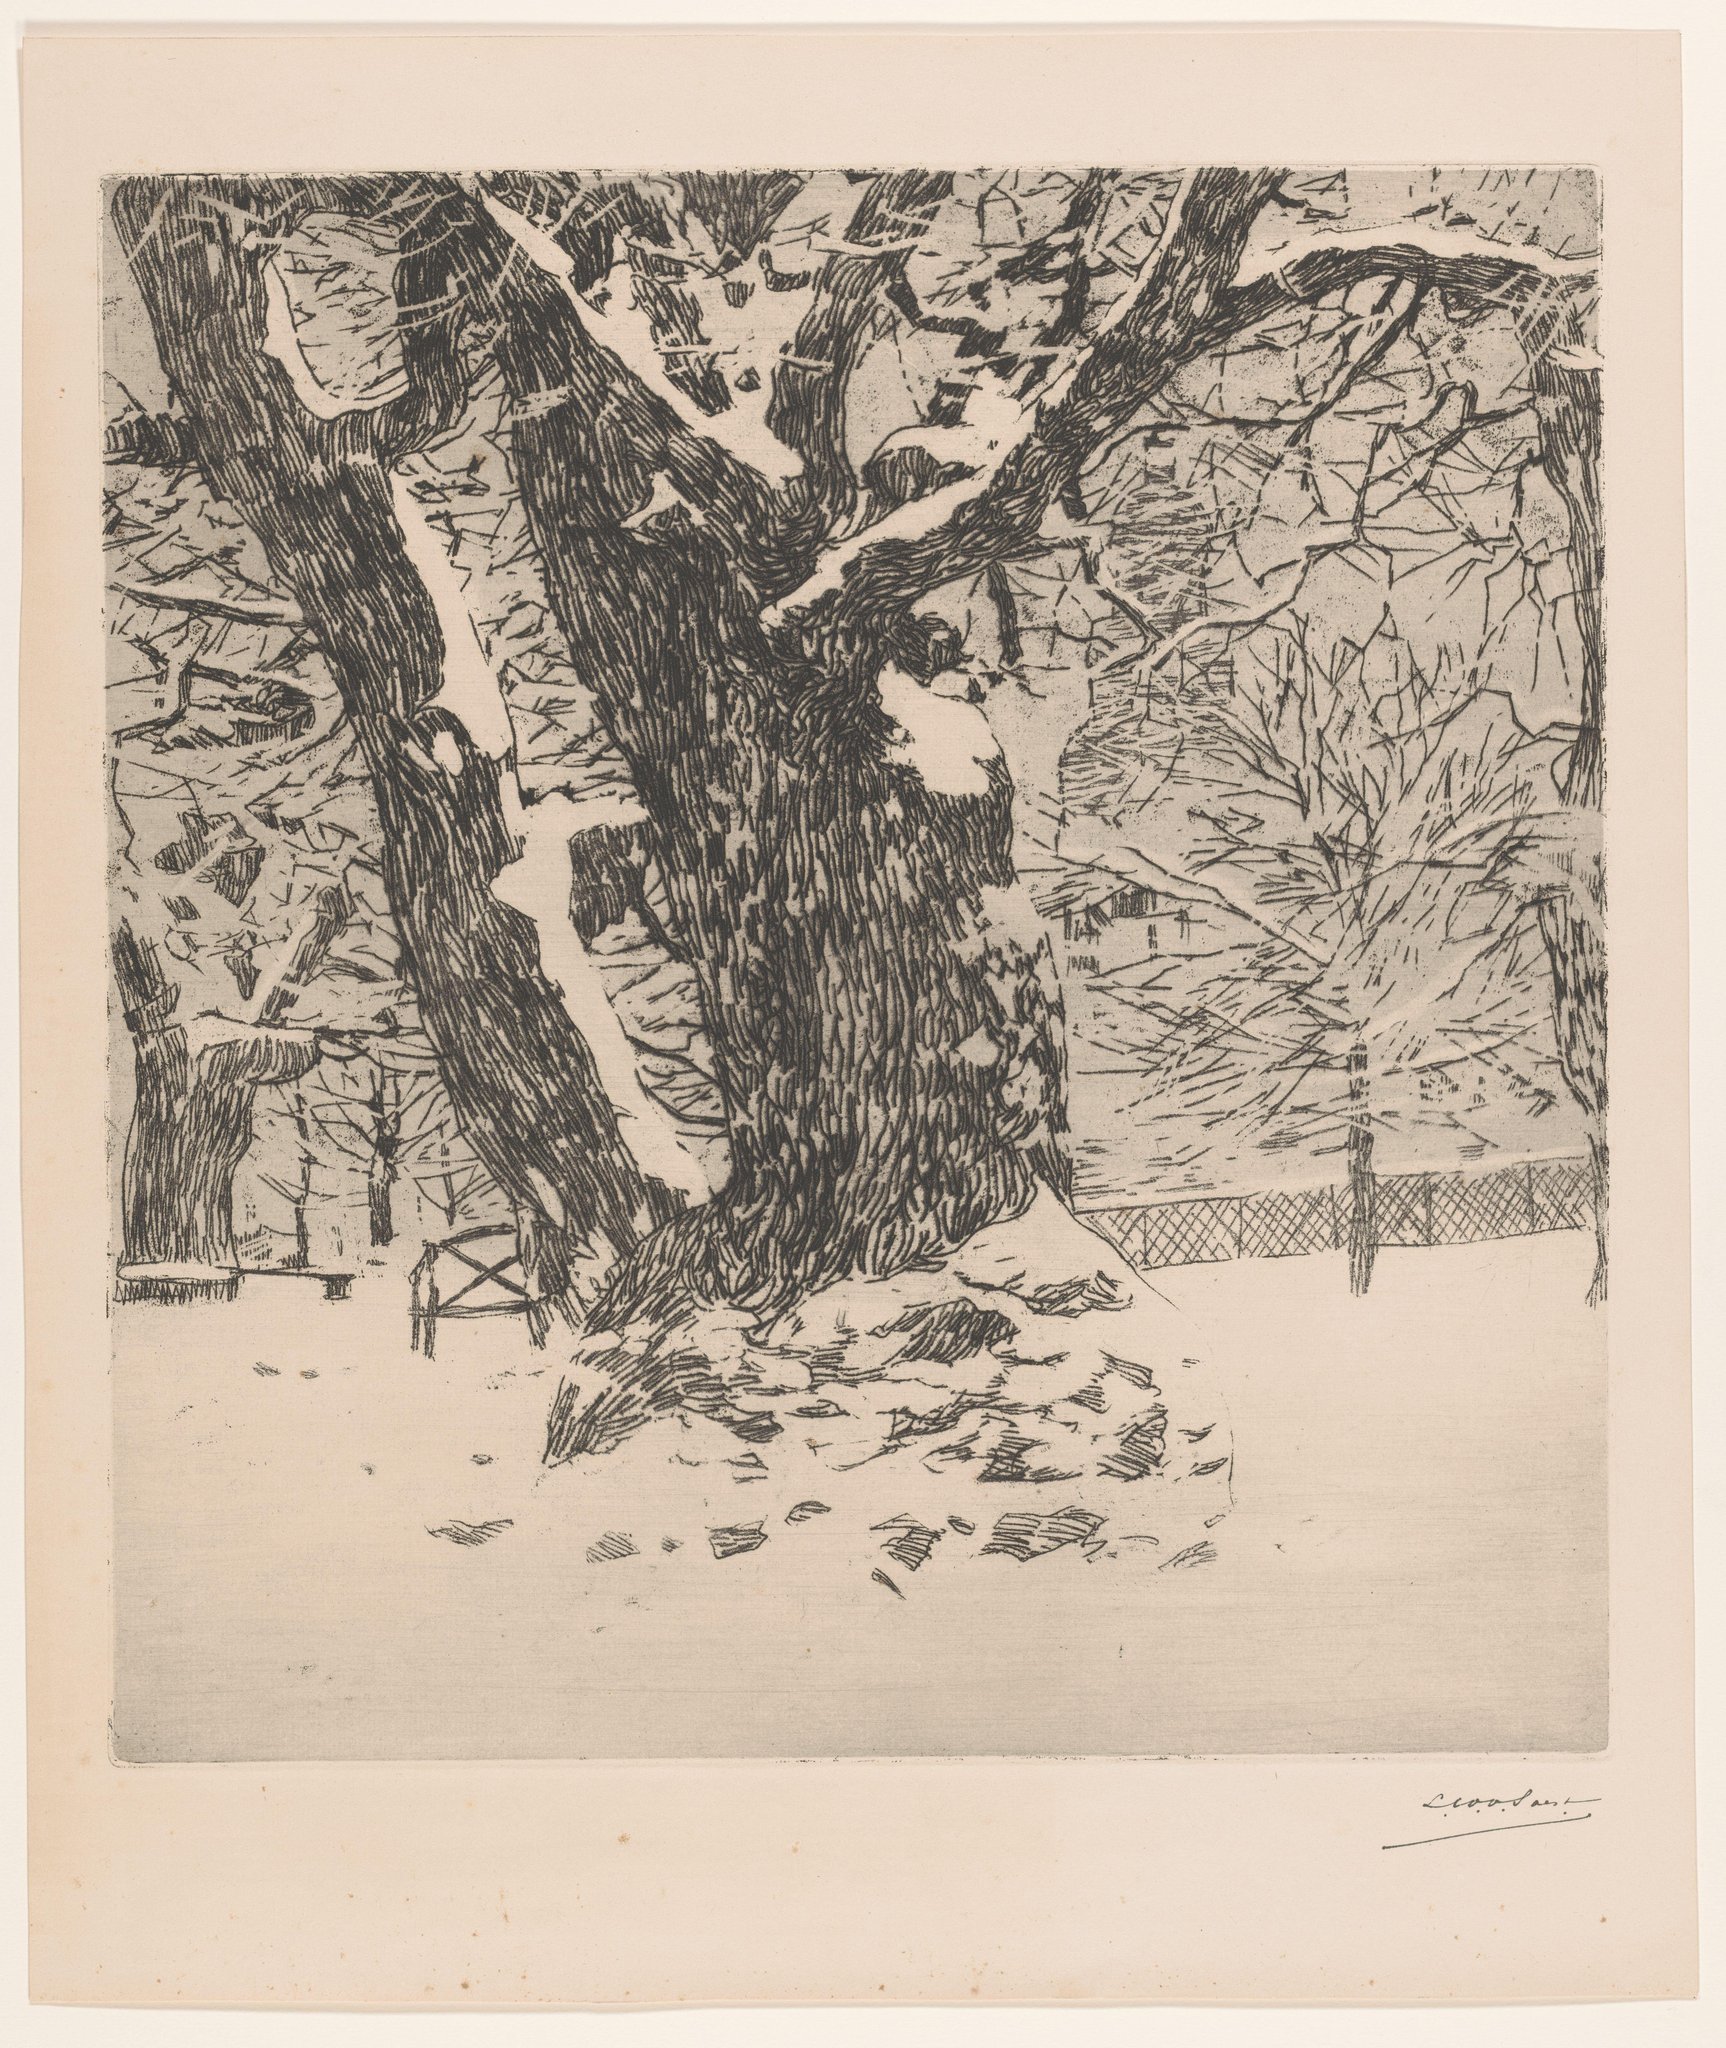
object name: print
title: Boom in een besneeuwd veld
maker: louis van soest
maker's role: print maker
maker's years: 1867-1948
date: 1877-1939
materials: paper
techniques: drypoint, intaglio, soft ground etching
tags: trees, snow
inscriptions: collector's mark: Lugt 2760, collector's mark: Lugt 2228